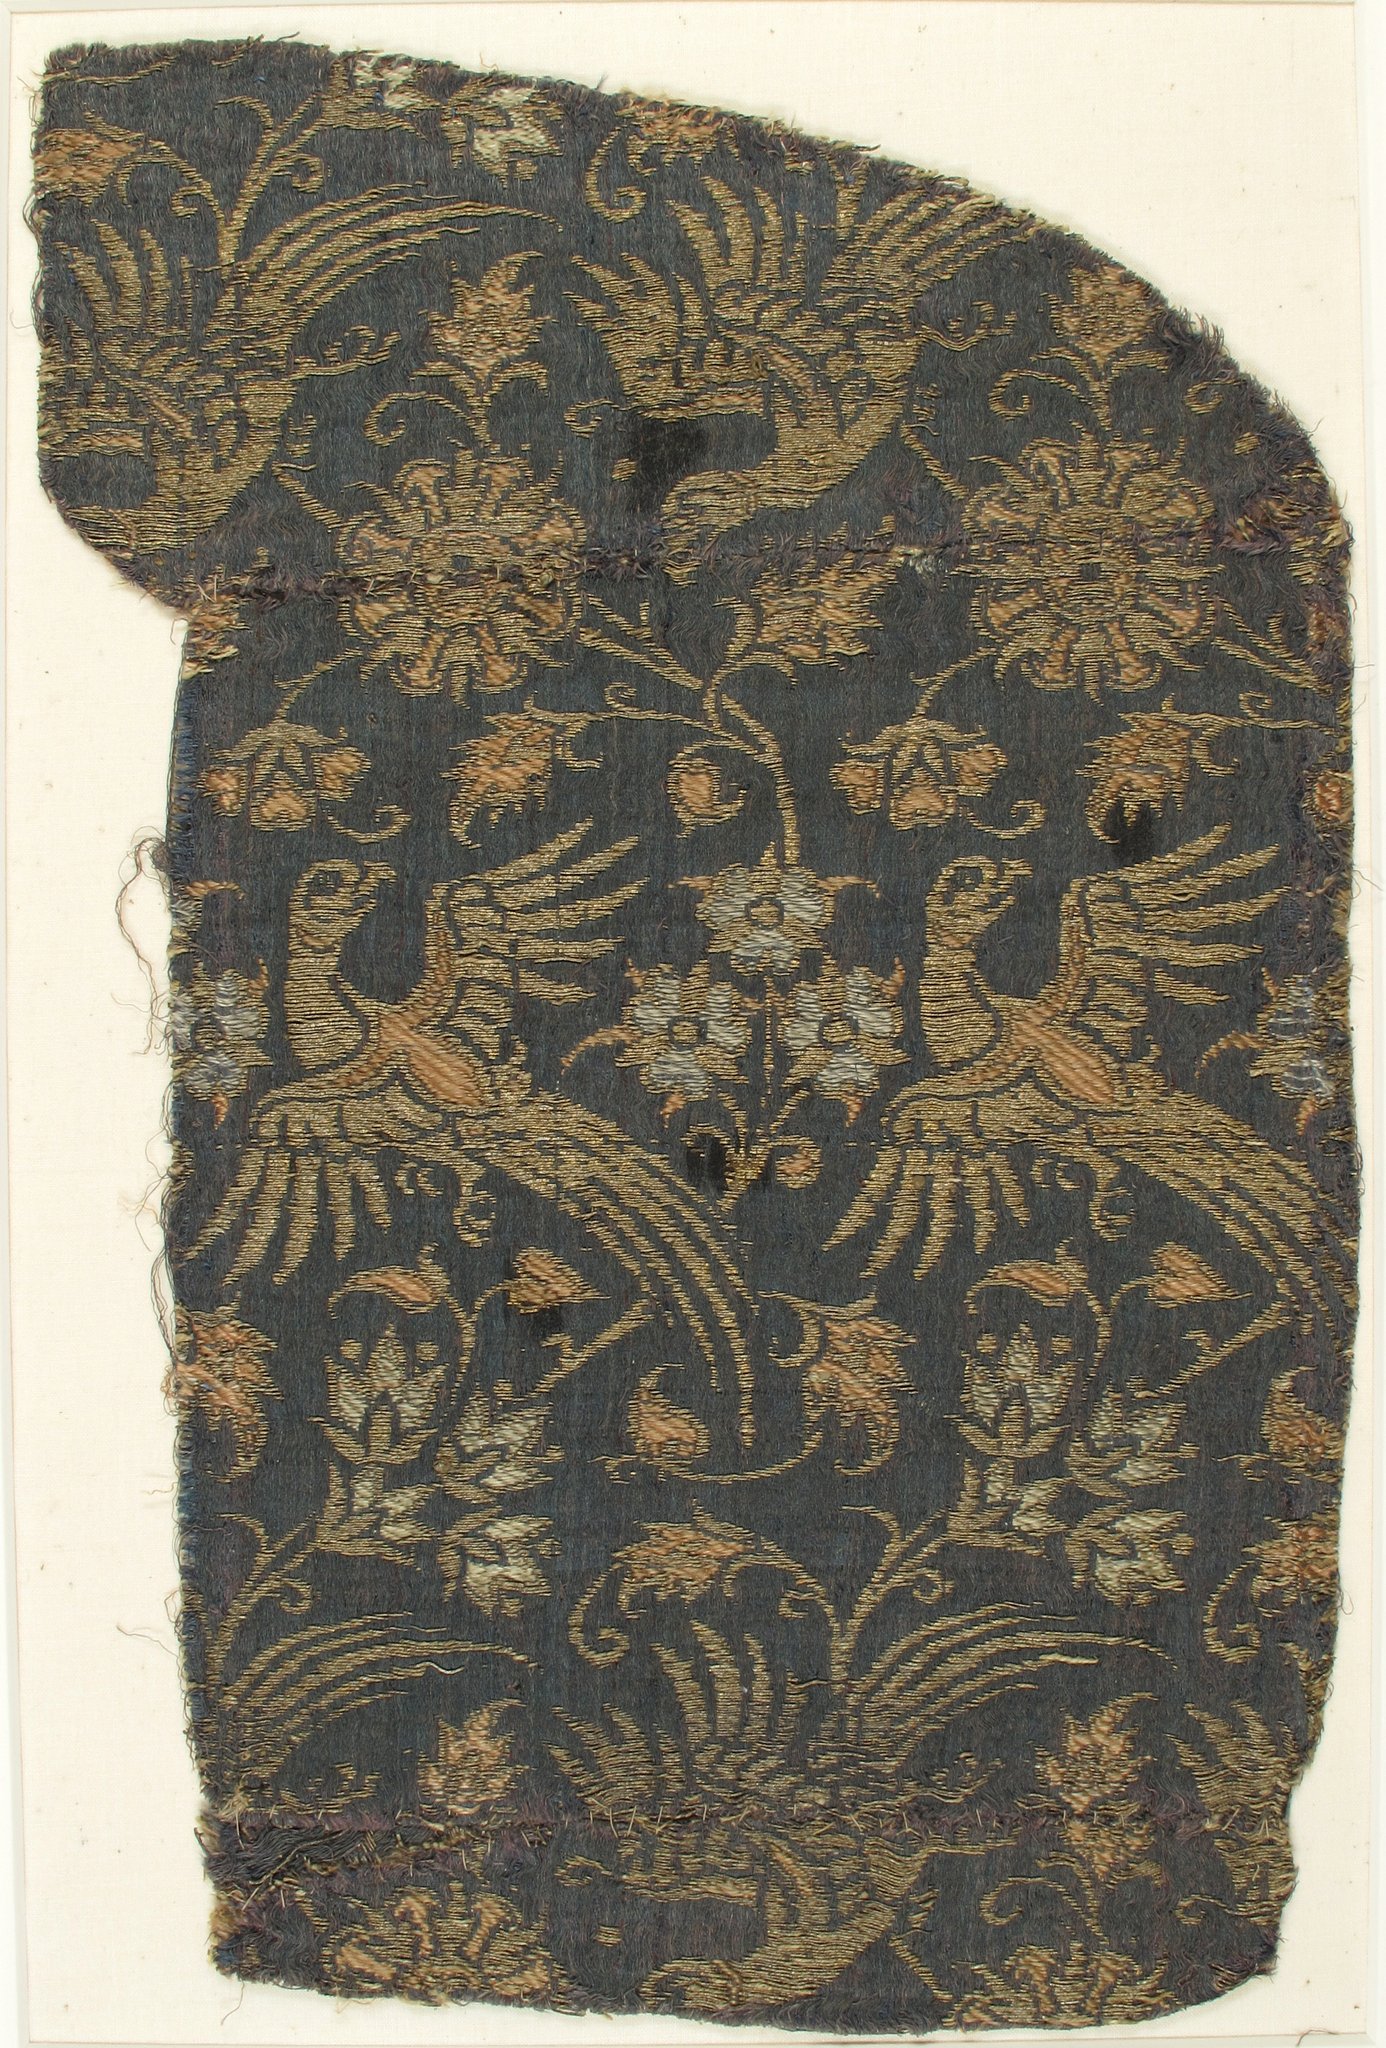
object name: textile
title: Textile with Brocade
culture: italian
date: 1301-1400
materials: linen, silk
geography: lucca (probably)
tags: birds